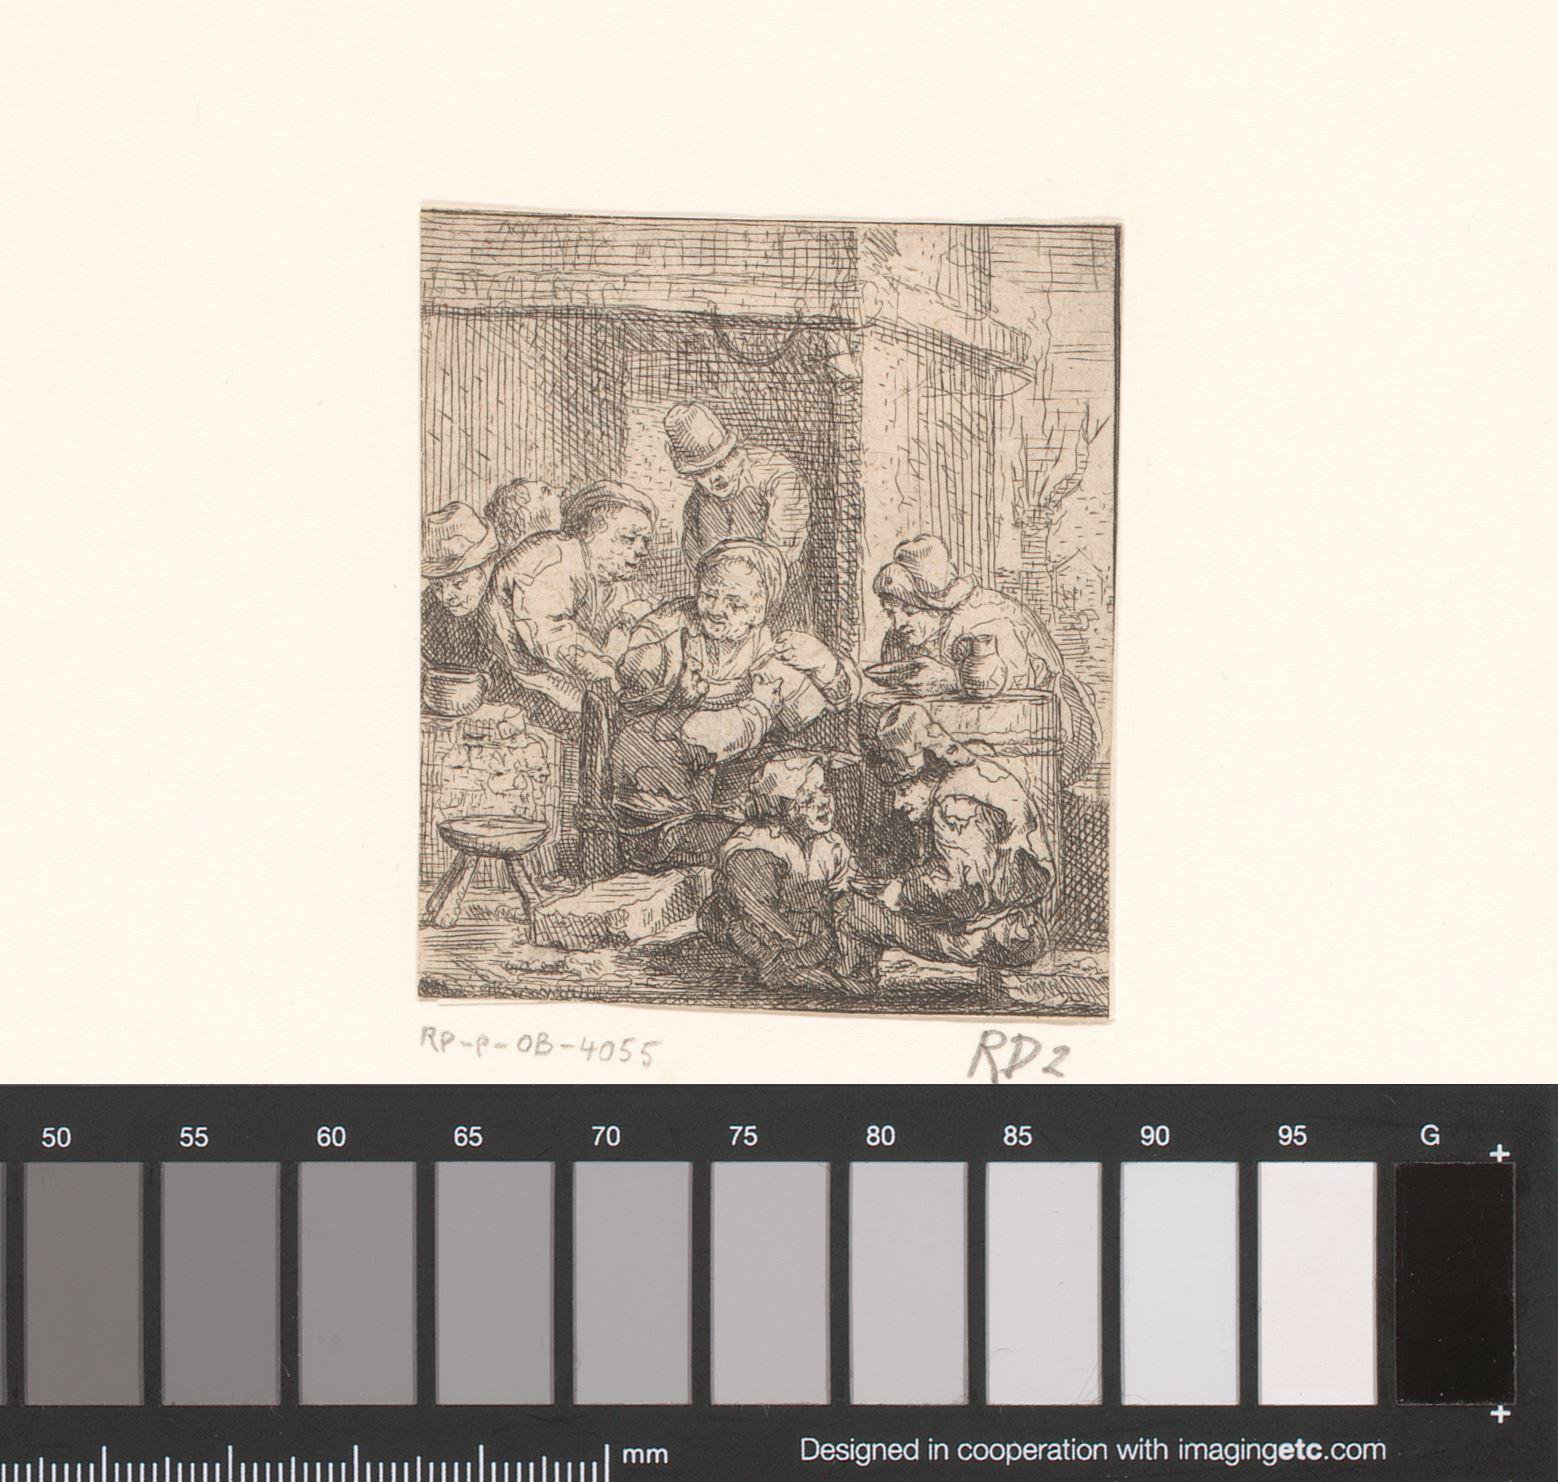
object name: print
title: Drinkend gezelschap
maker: jacques dassonville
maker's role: print maker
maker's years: 1619-1670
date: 1629-1670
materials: paper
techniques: engraving, etching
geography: france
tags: beer, ale, drinking, private festivities, merry company